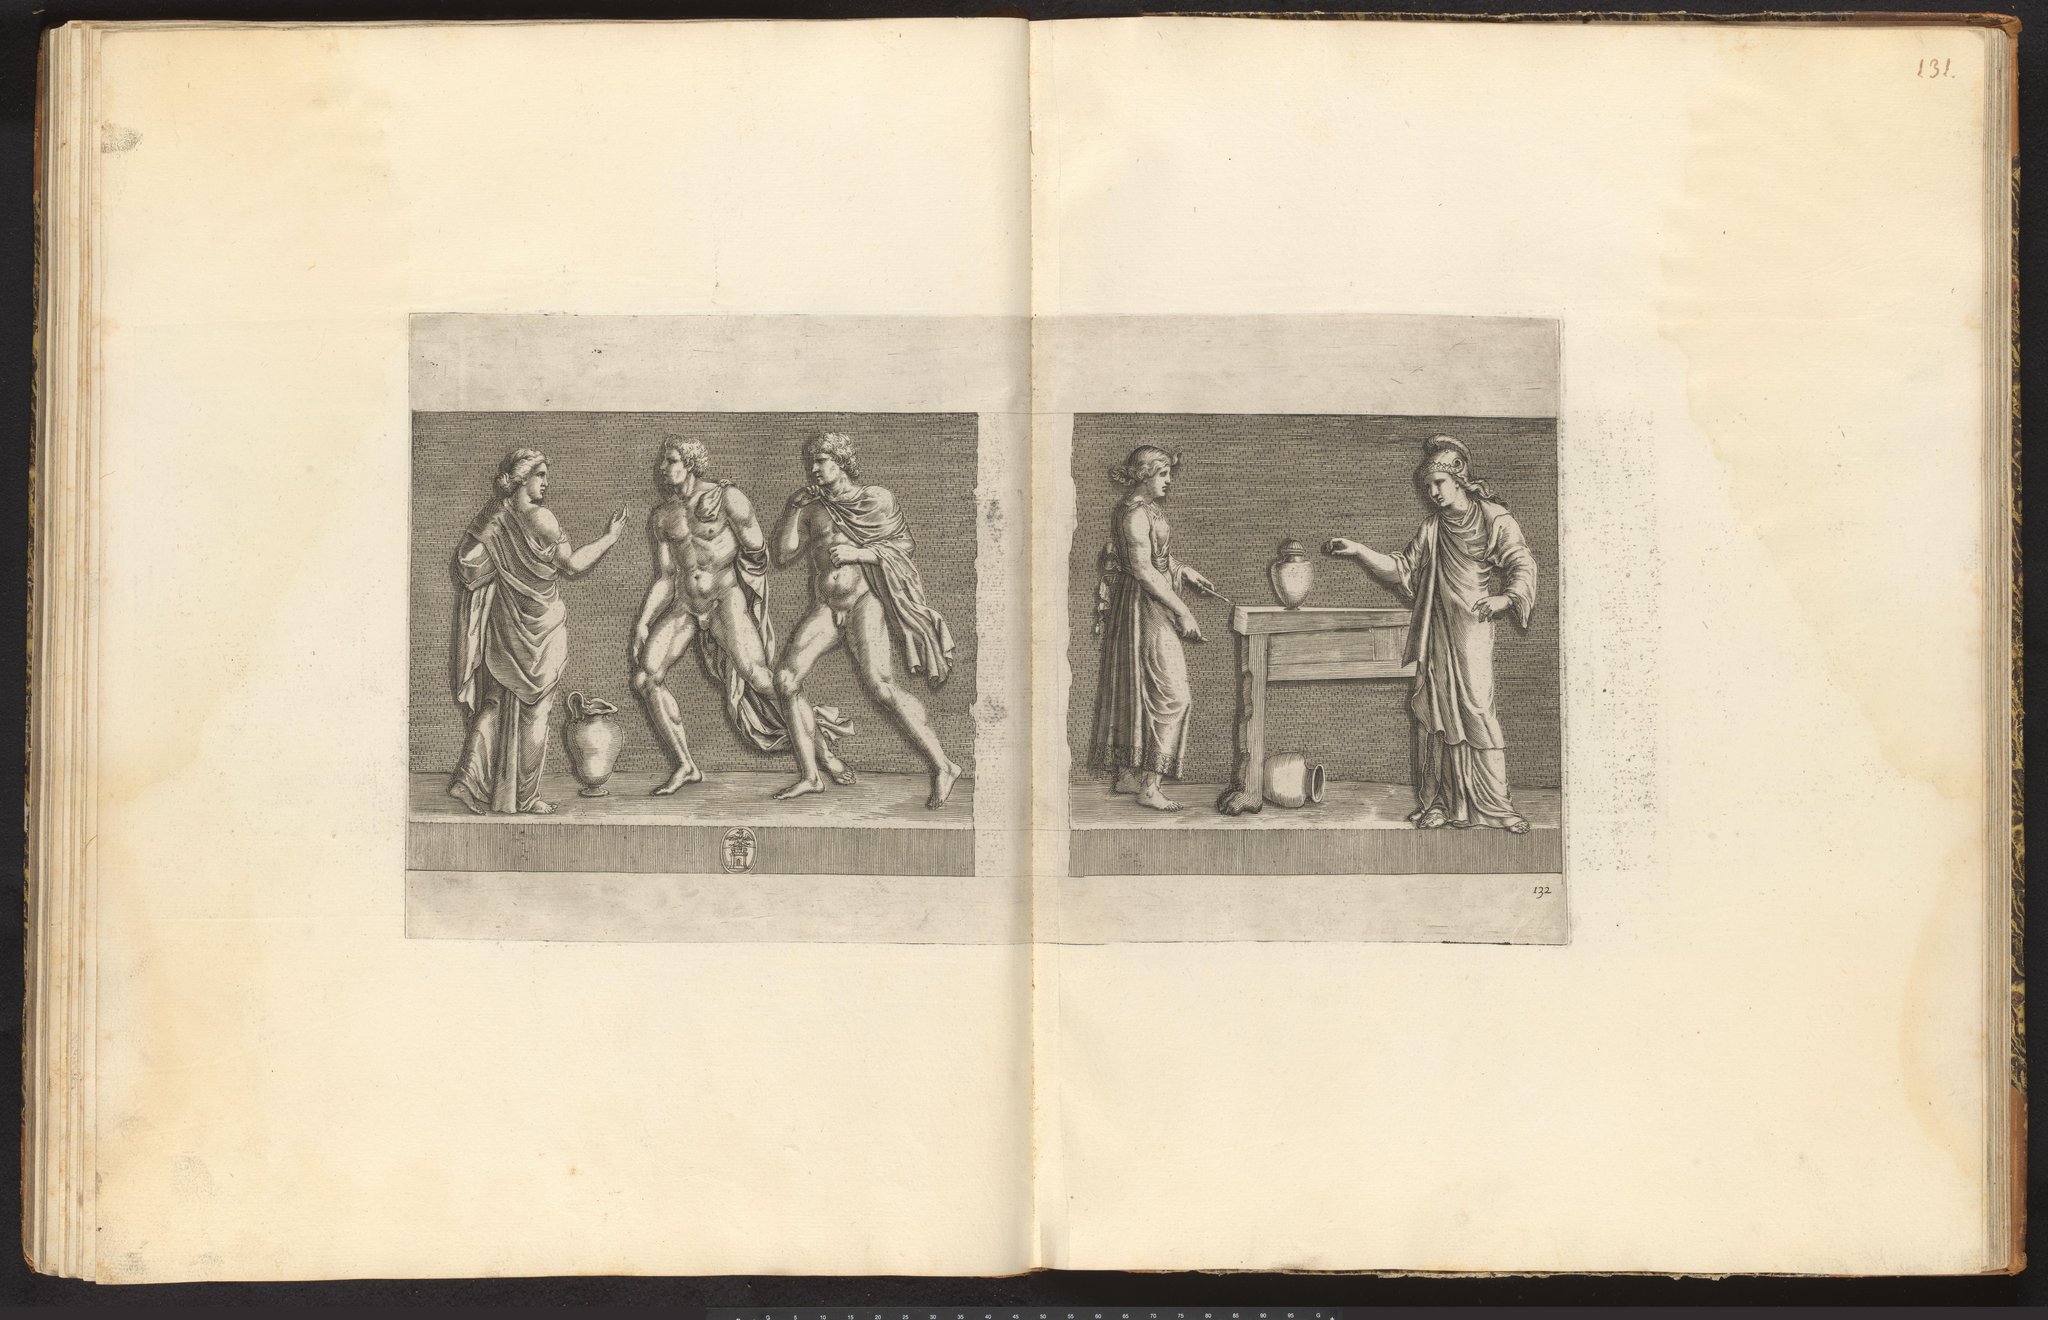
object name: album leaf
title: Bas-reliëfs met voorstellingen van vrouwen en mannen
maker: matthäus greuter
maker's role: print maker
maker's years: 1564-1638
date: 1636-1647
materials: paper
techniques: engraving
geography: rome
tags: piece of sculpture, reproduction of a piece of sculpture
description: Twee bas-reliëfs. Links een vrouw die twee mannen wenkt. Rechts twee vrouwen bij een tafel. De rechter vrouw heeft een helm op het hoofd. Wellicht een voorstelling van Minerva. Linksonder het wapenschild van Vincenzo Giustiniani. Prent maakt deel uit van een album met een serie prenten naar de sculpturen in de verzameling in de Galleria Giustiniani te Rome.